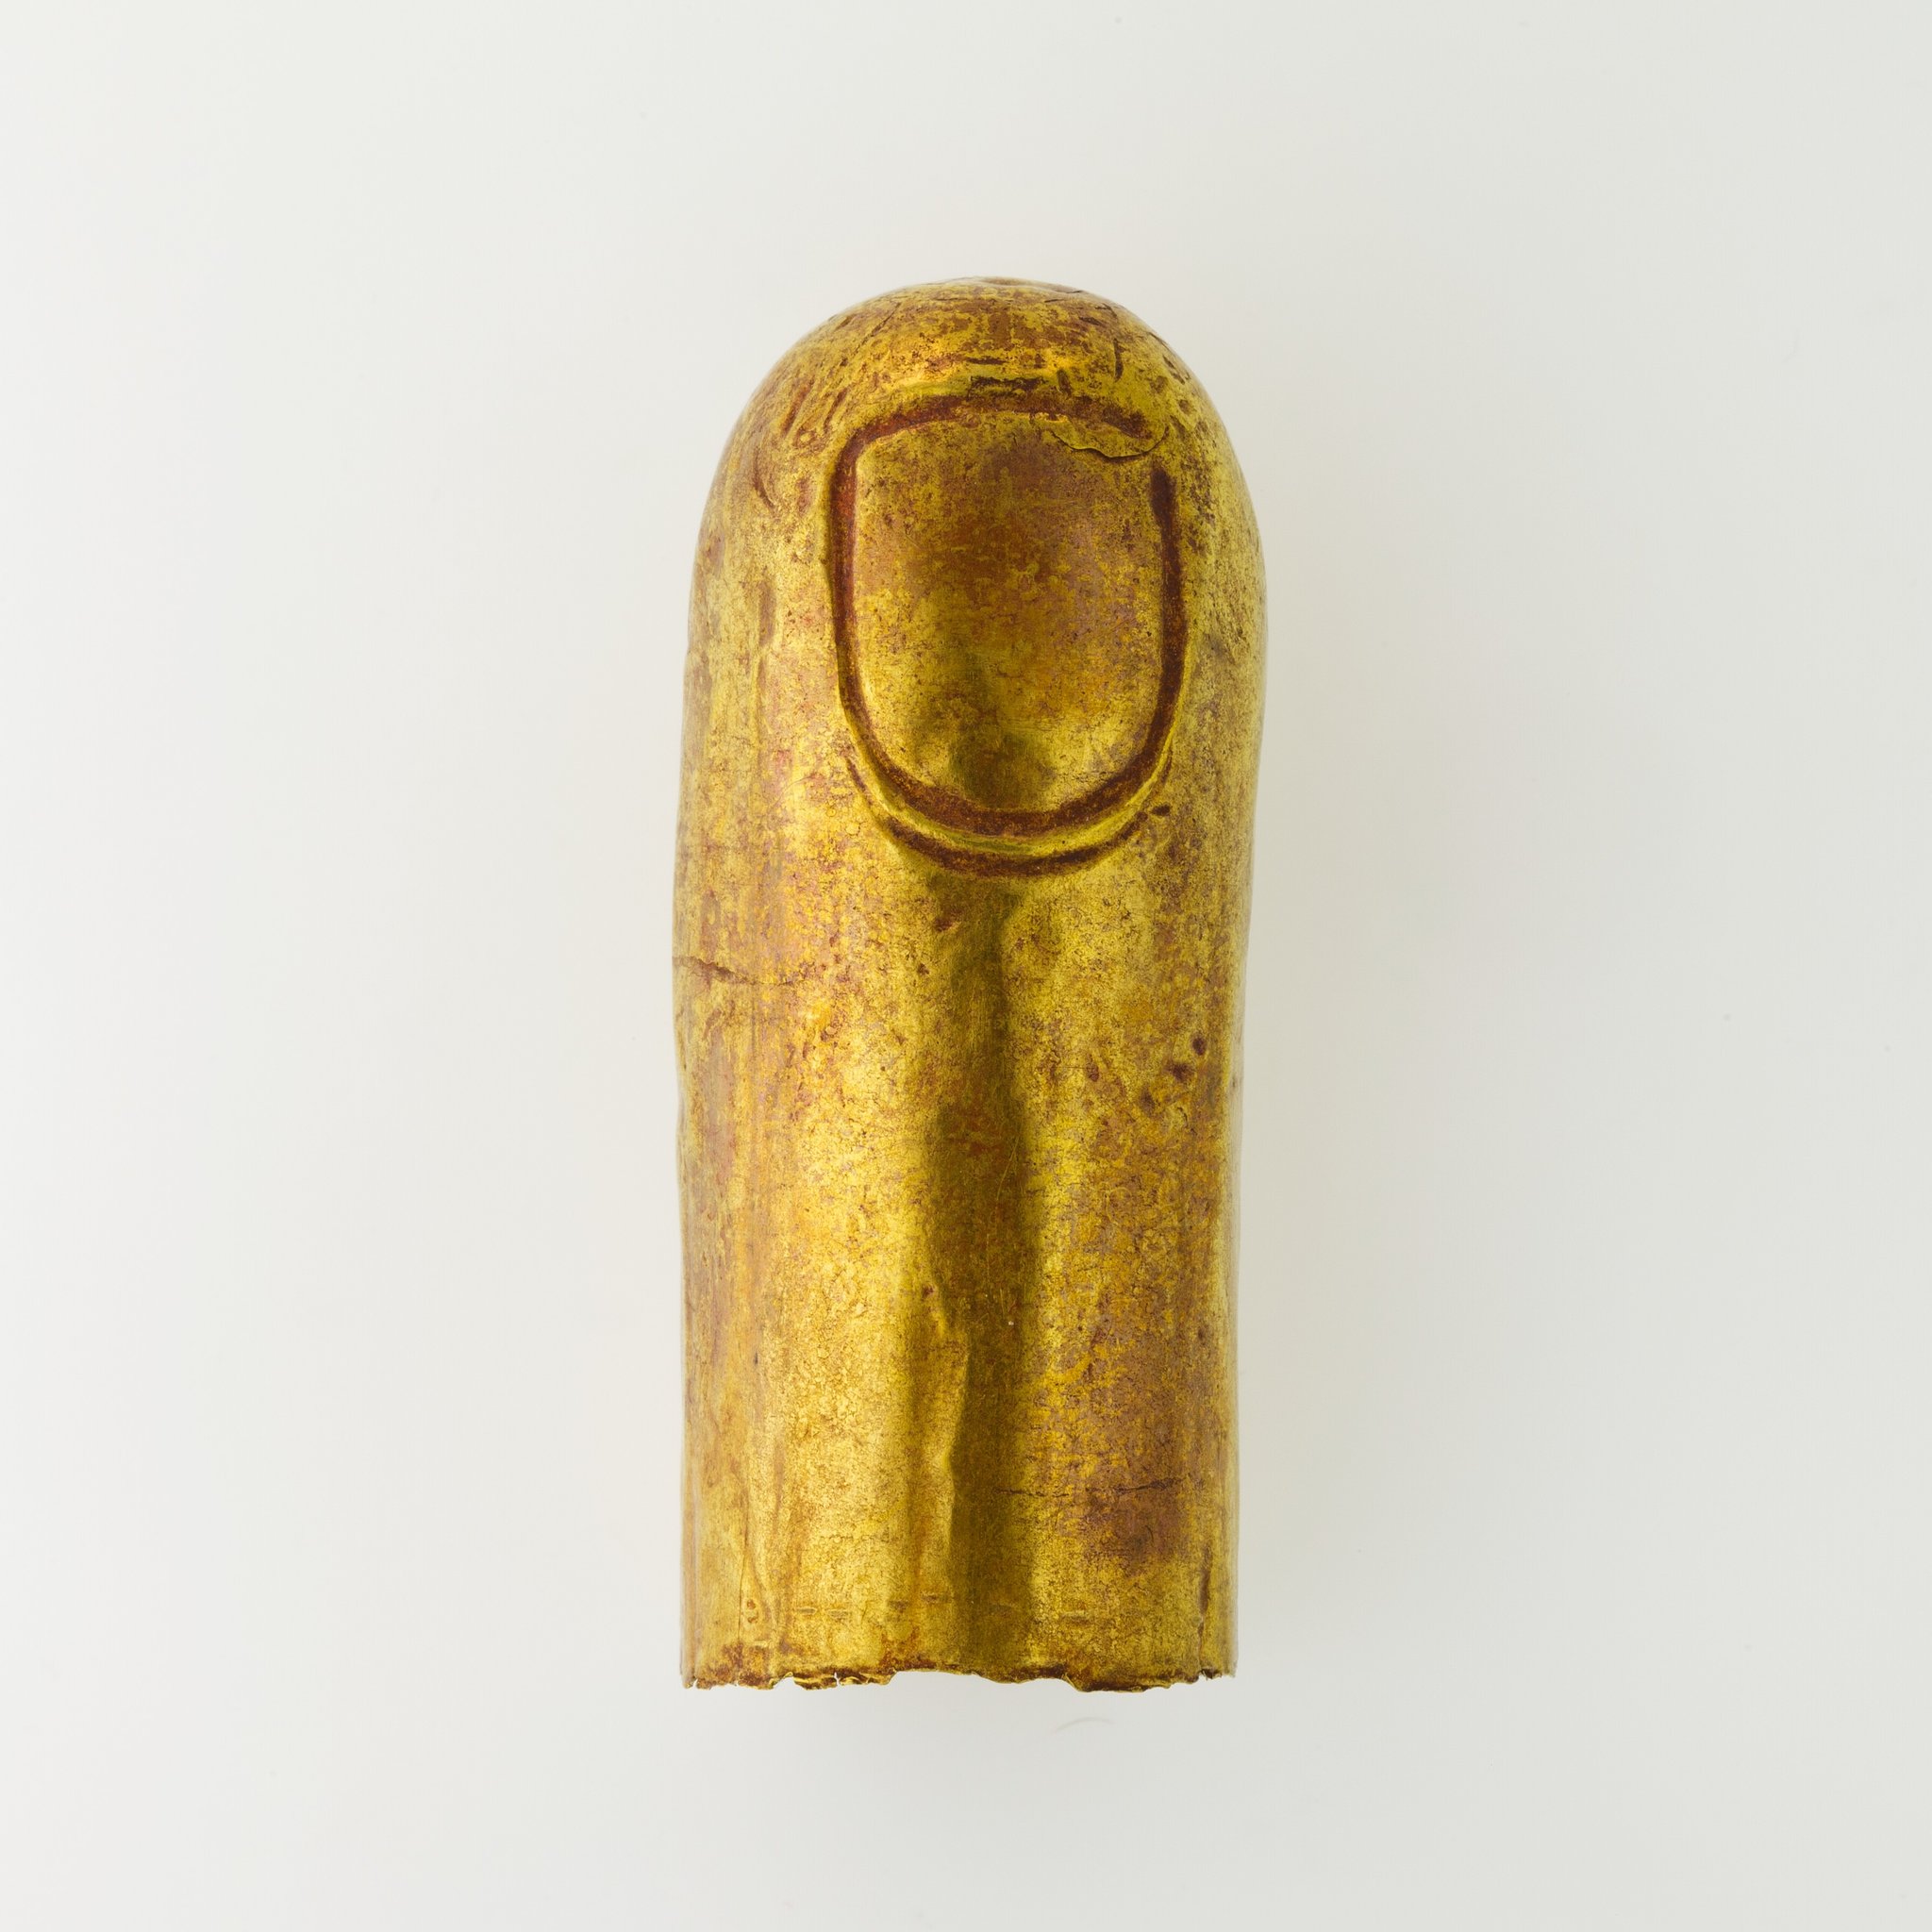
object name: finger stall, group 1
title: Finger stall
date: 1479-1425 BCE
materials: gold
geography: egypt